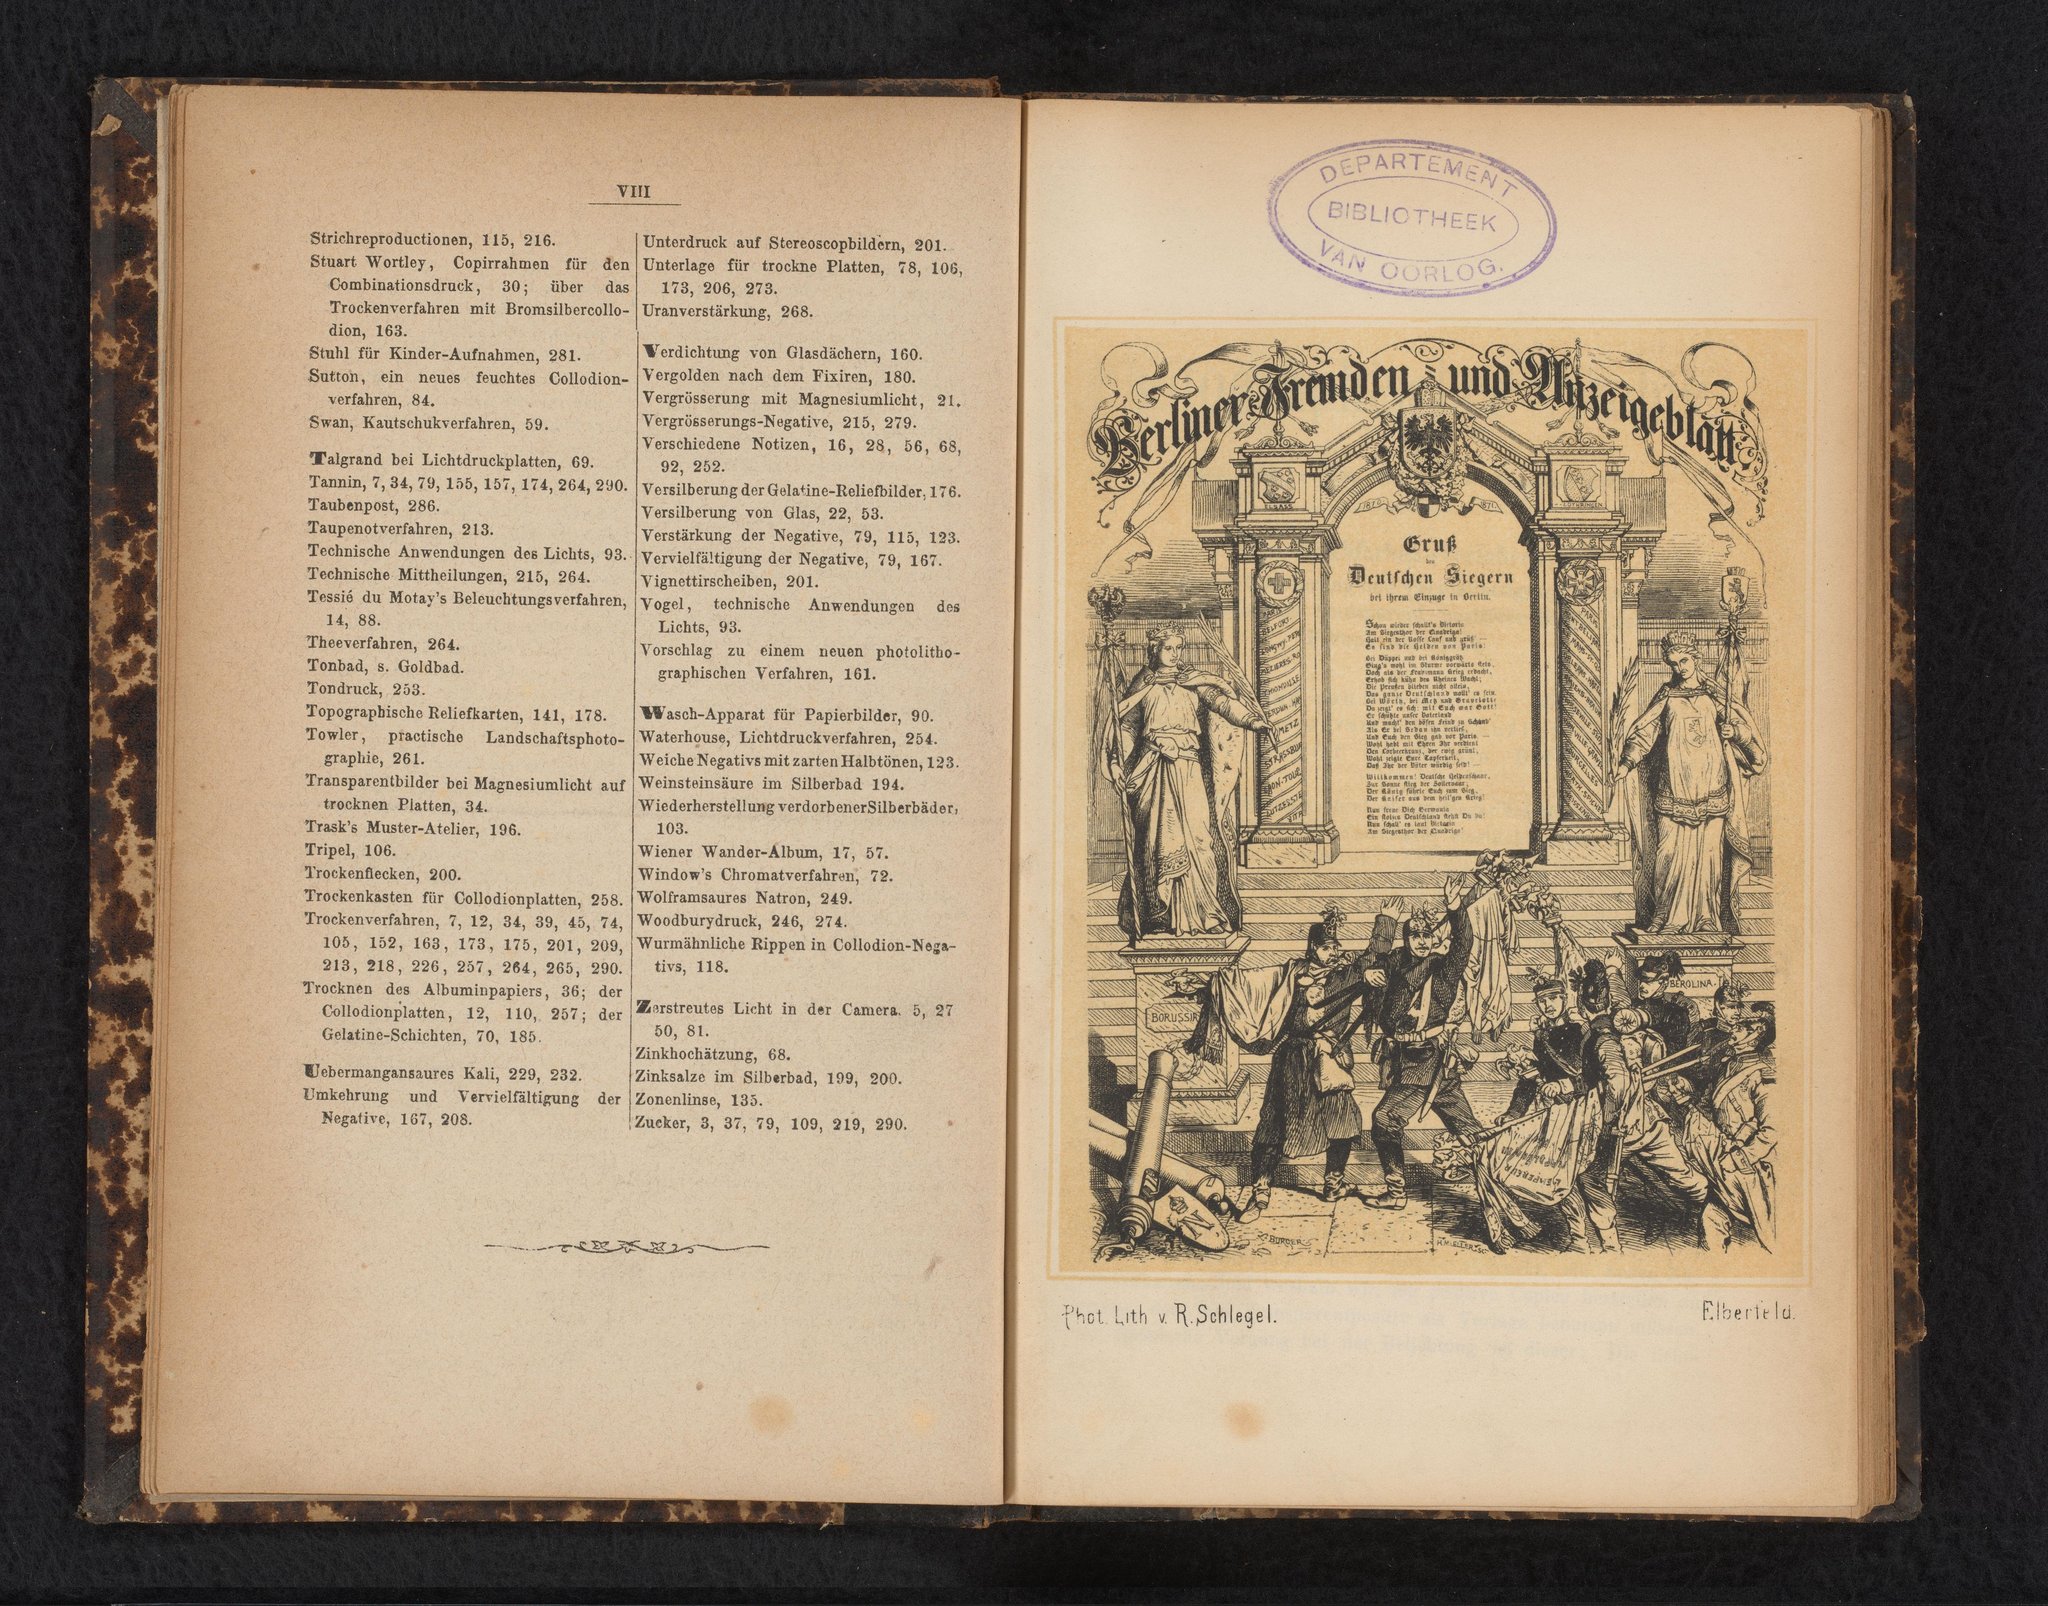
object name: photomechanical print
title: Reproductie van het titelblad van het Berliner Fremden- und Anzeigeblatt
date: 1870-1871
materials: cardboard, paper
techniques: photolithography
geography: elberfeld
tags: conqueror triumphing, triumphal entry of victor